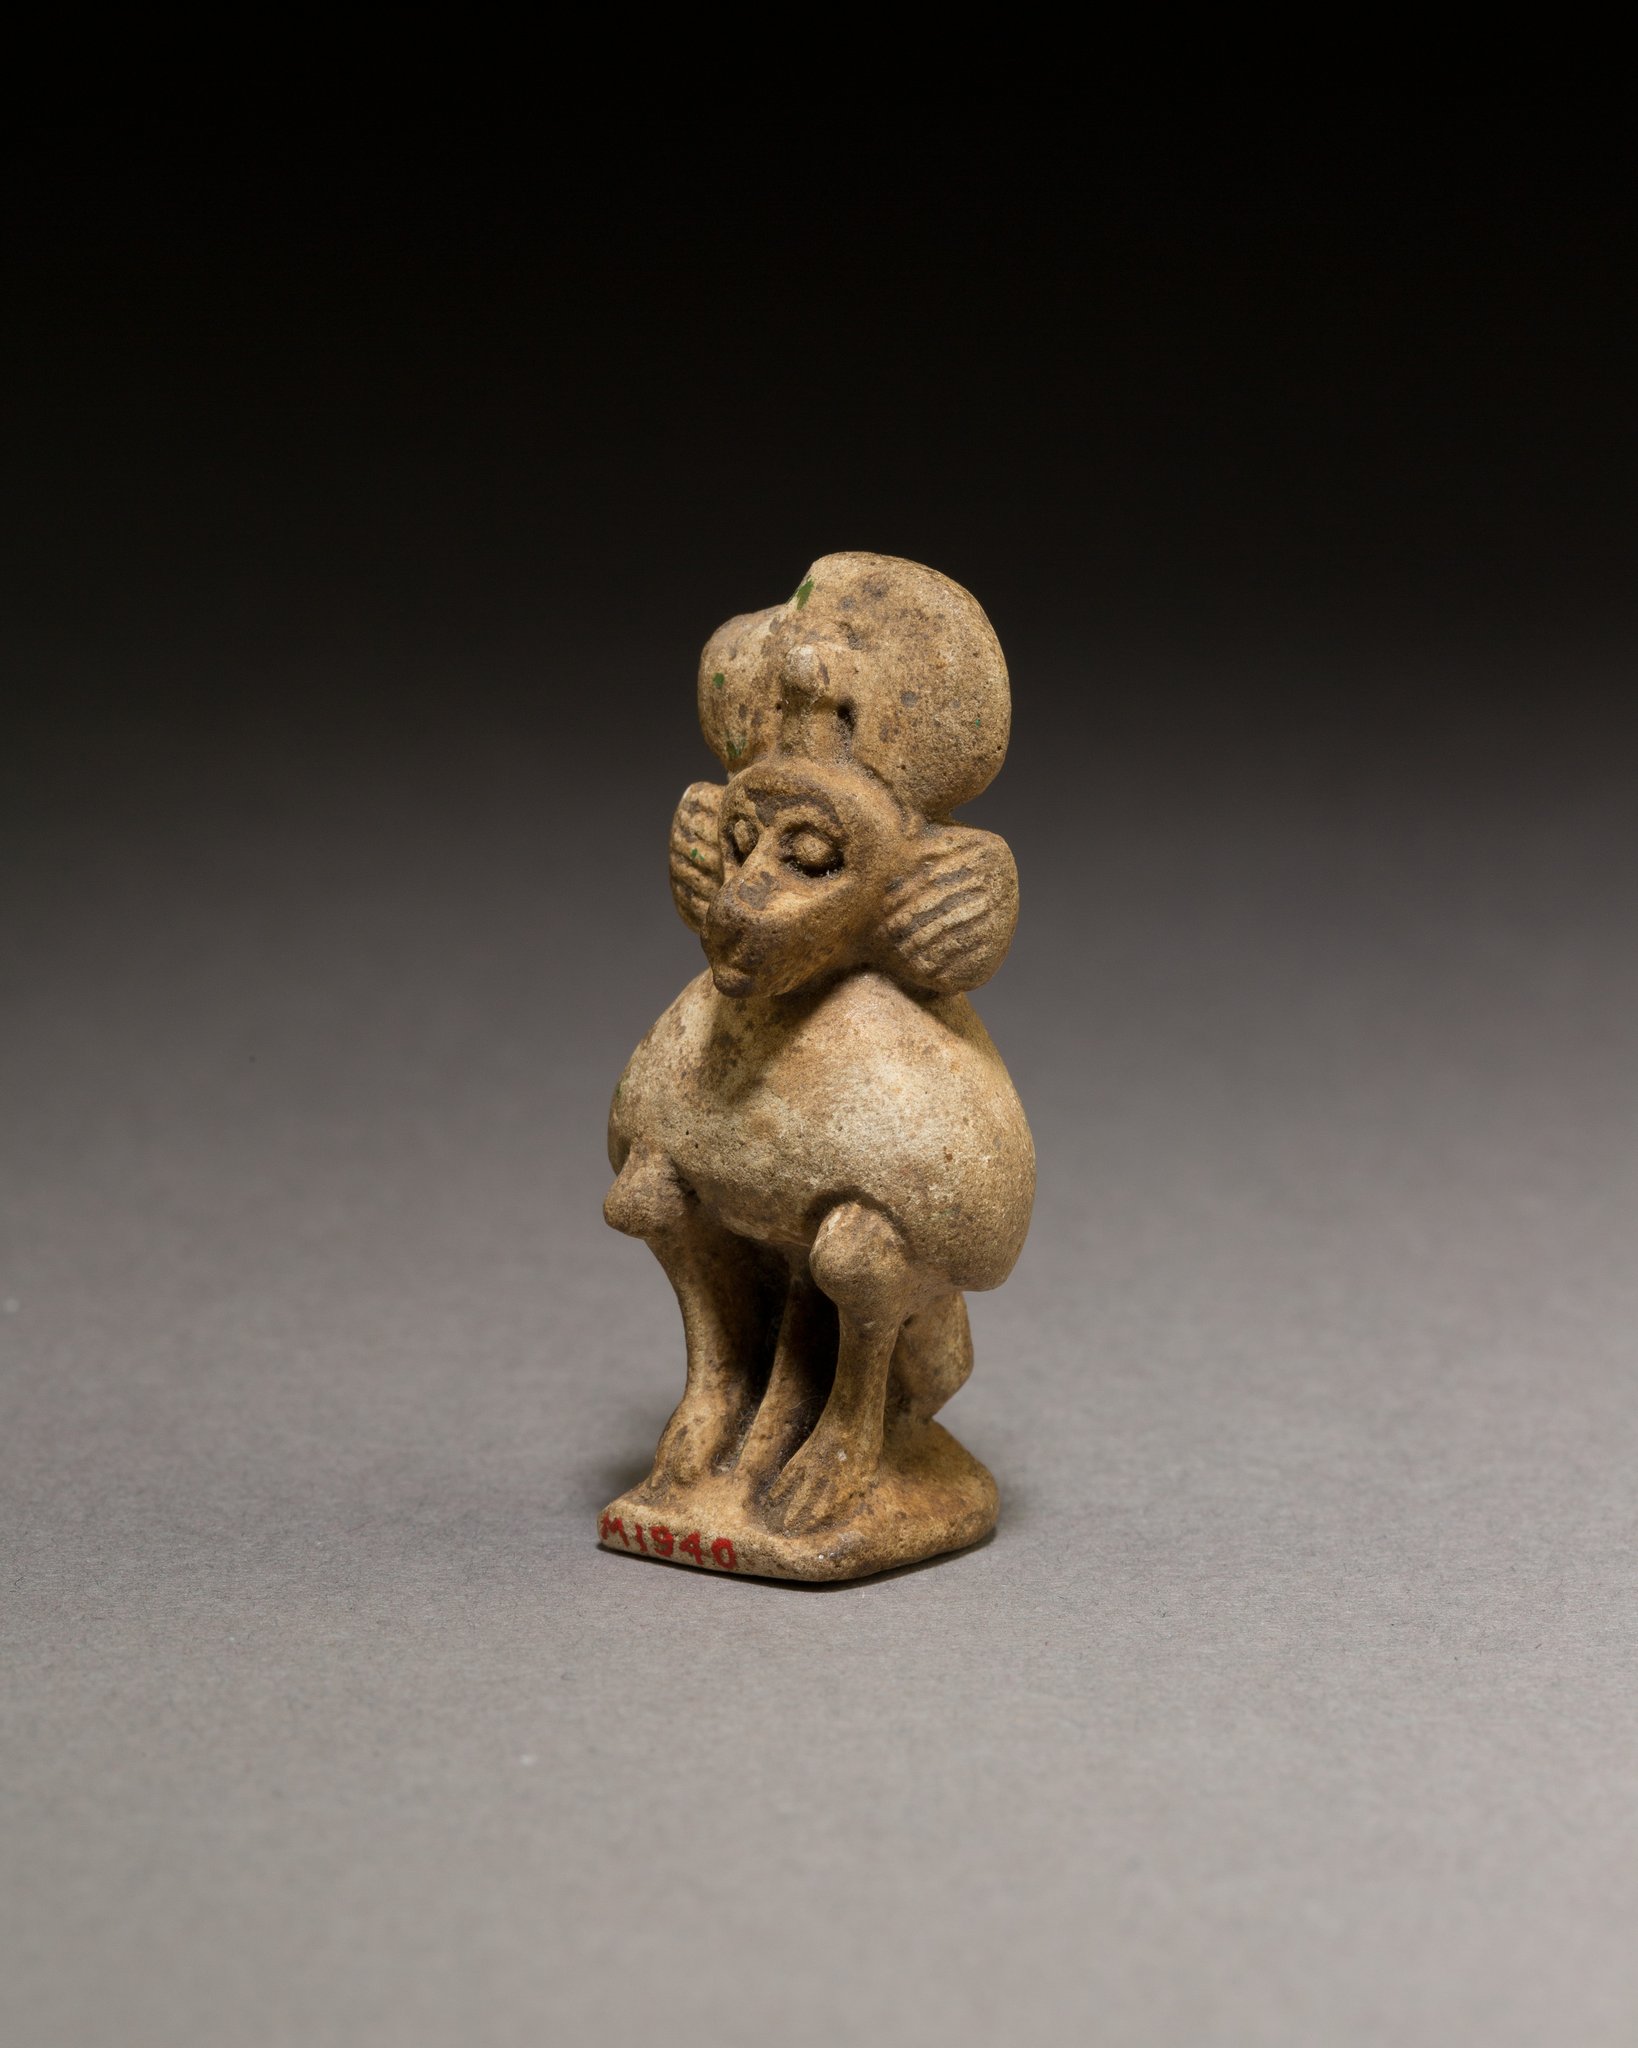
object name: figurine, baboon, thoth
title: Thoth as baboon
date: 332-330 BCE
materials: faience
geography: egypt